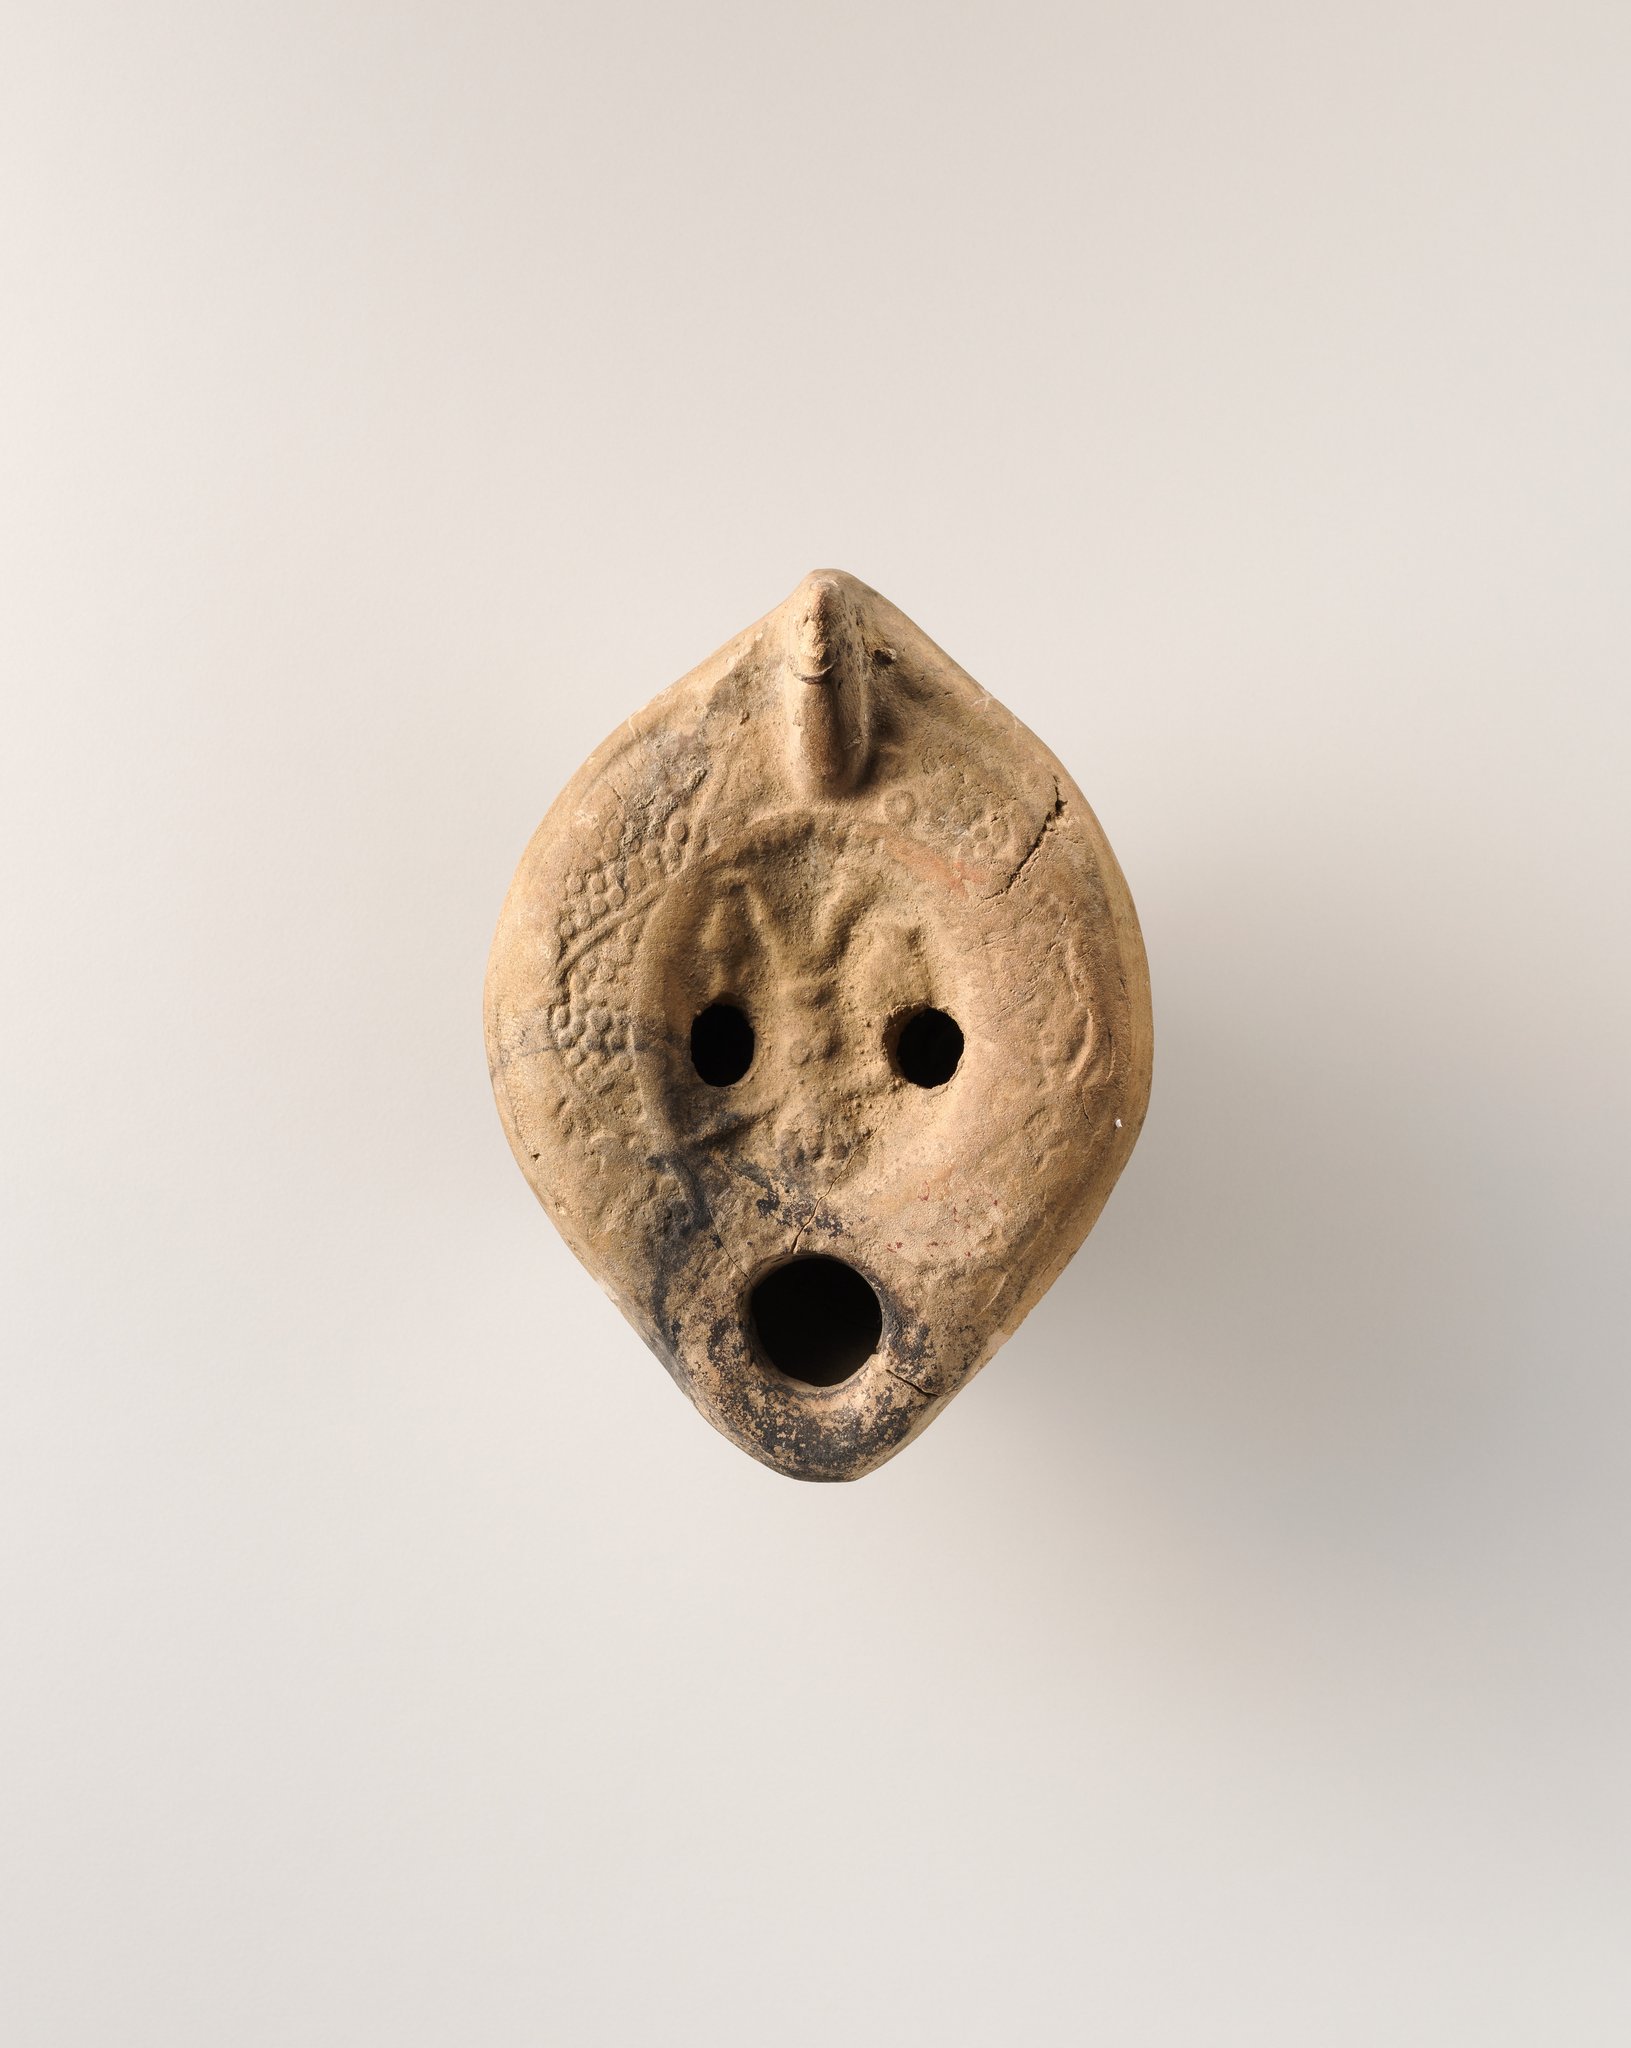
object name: lamp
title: Terracotta oil lamp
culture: roman, cypriot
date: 201-400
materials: terracotta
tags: men